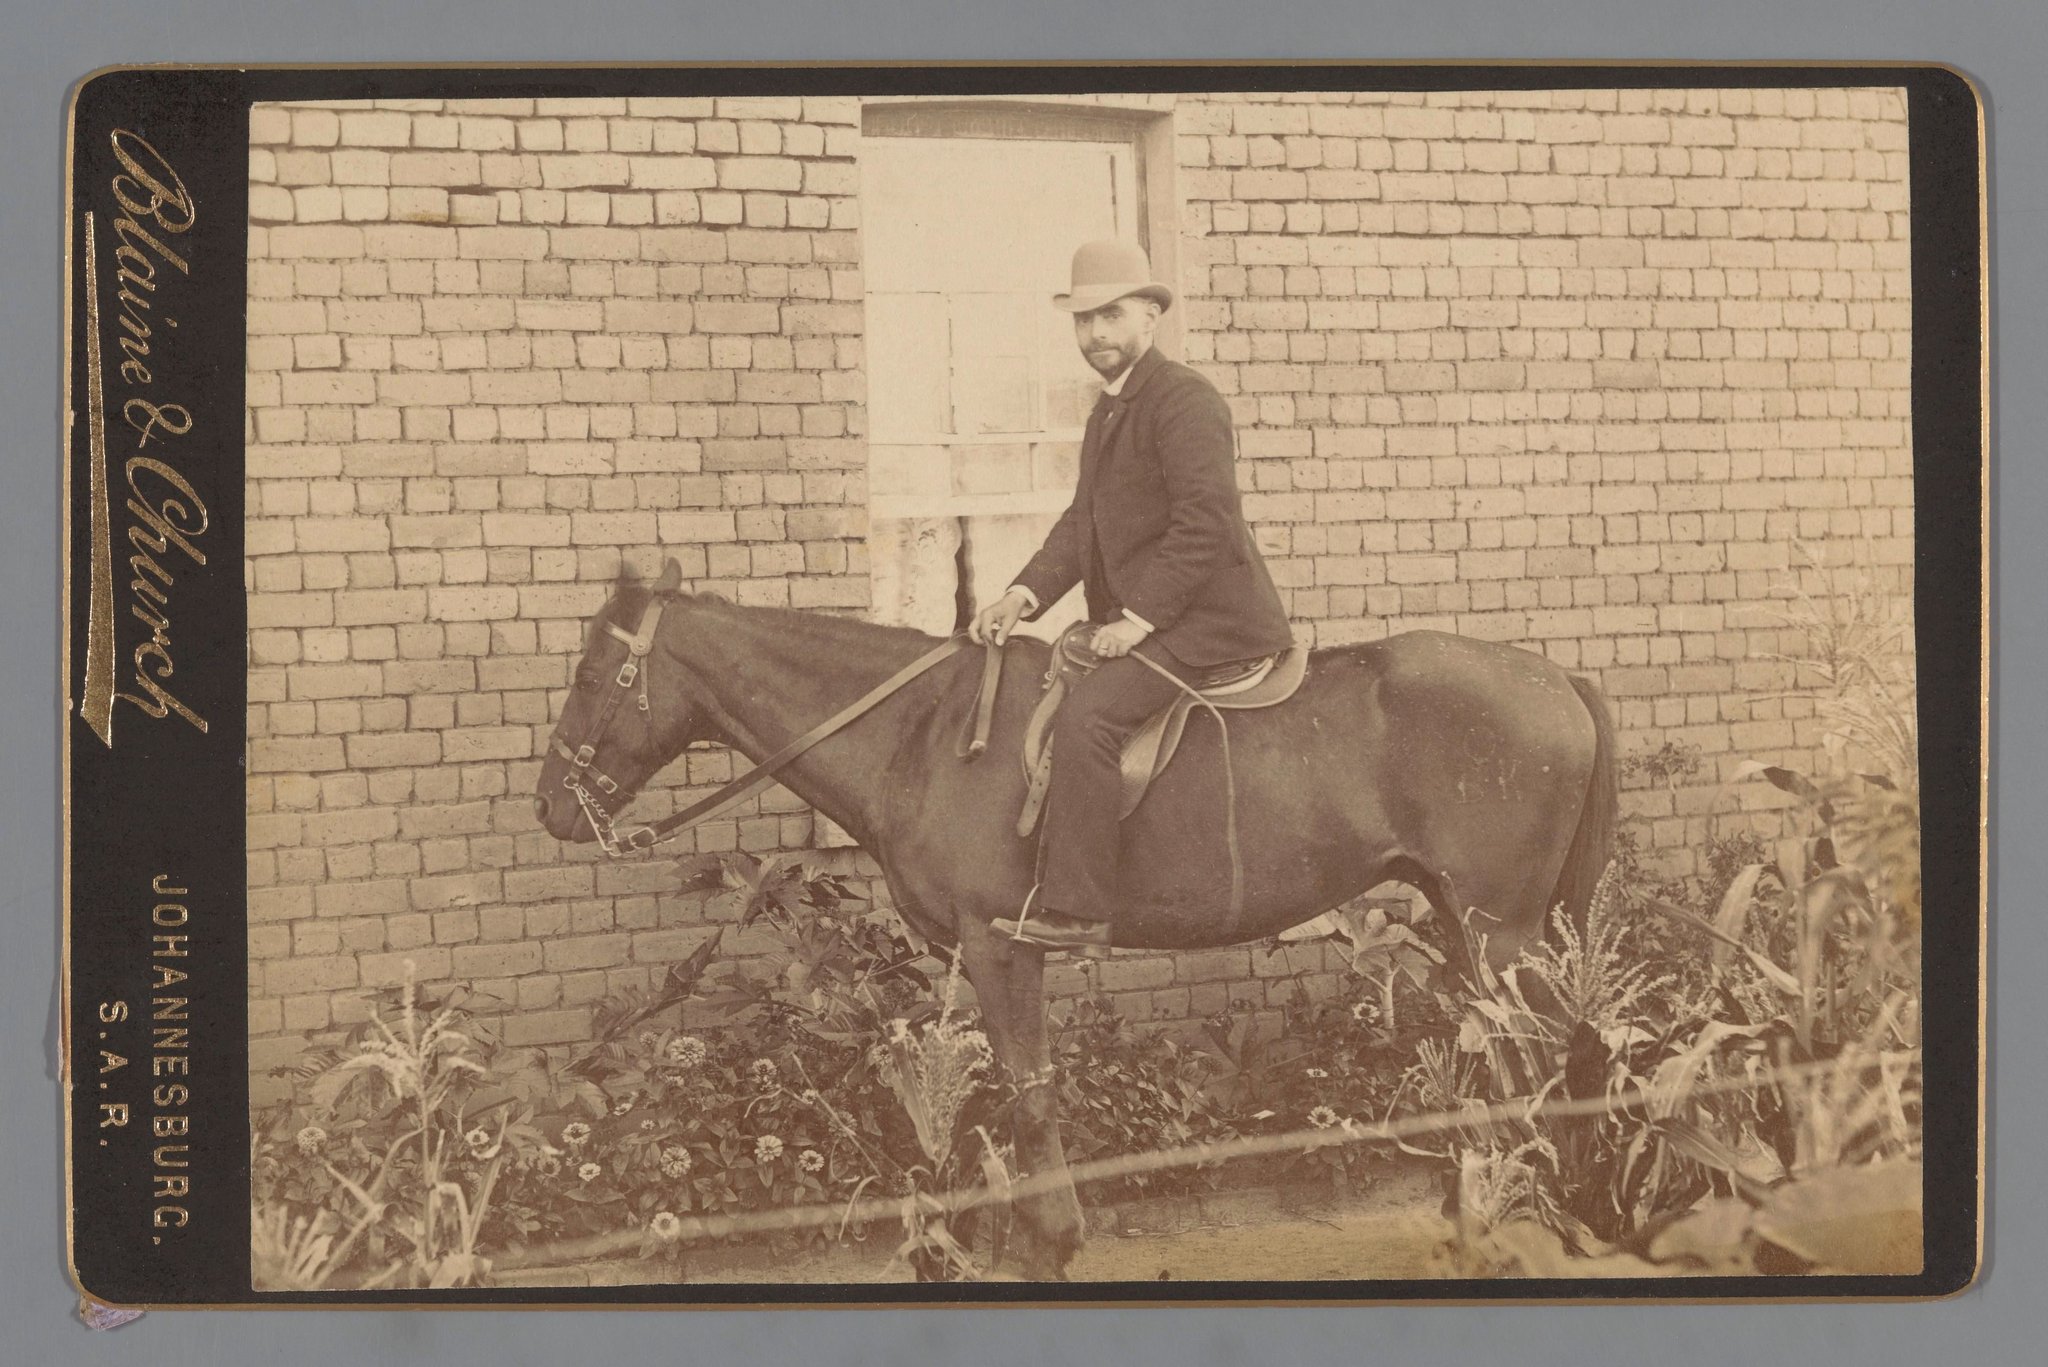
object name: photograph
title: Portret van een onbekende man op een paard voor een woning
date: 1875-1890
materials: cardboard, photographic support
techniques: albumen print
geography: johannesburg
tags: riding a horse, ass, or mule; rider, horseman